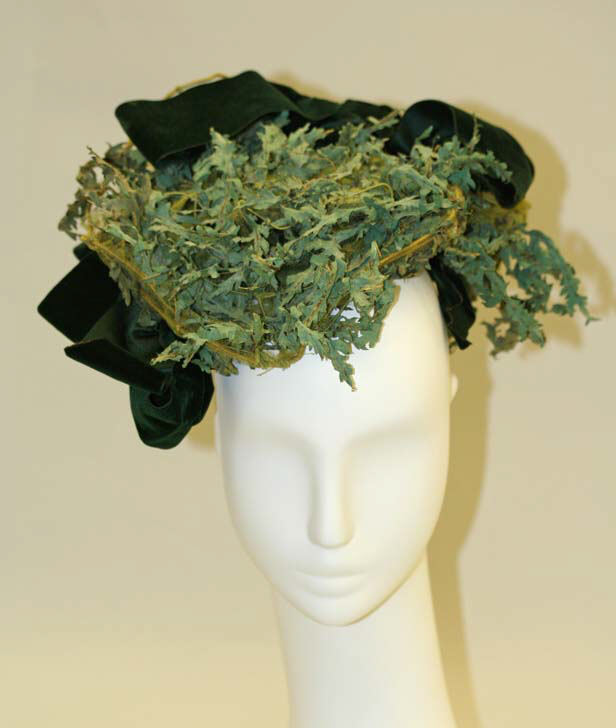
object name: hat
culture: american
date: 1895-1897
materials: cotton, silk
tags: leaves